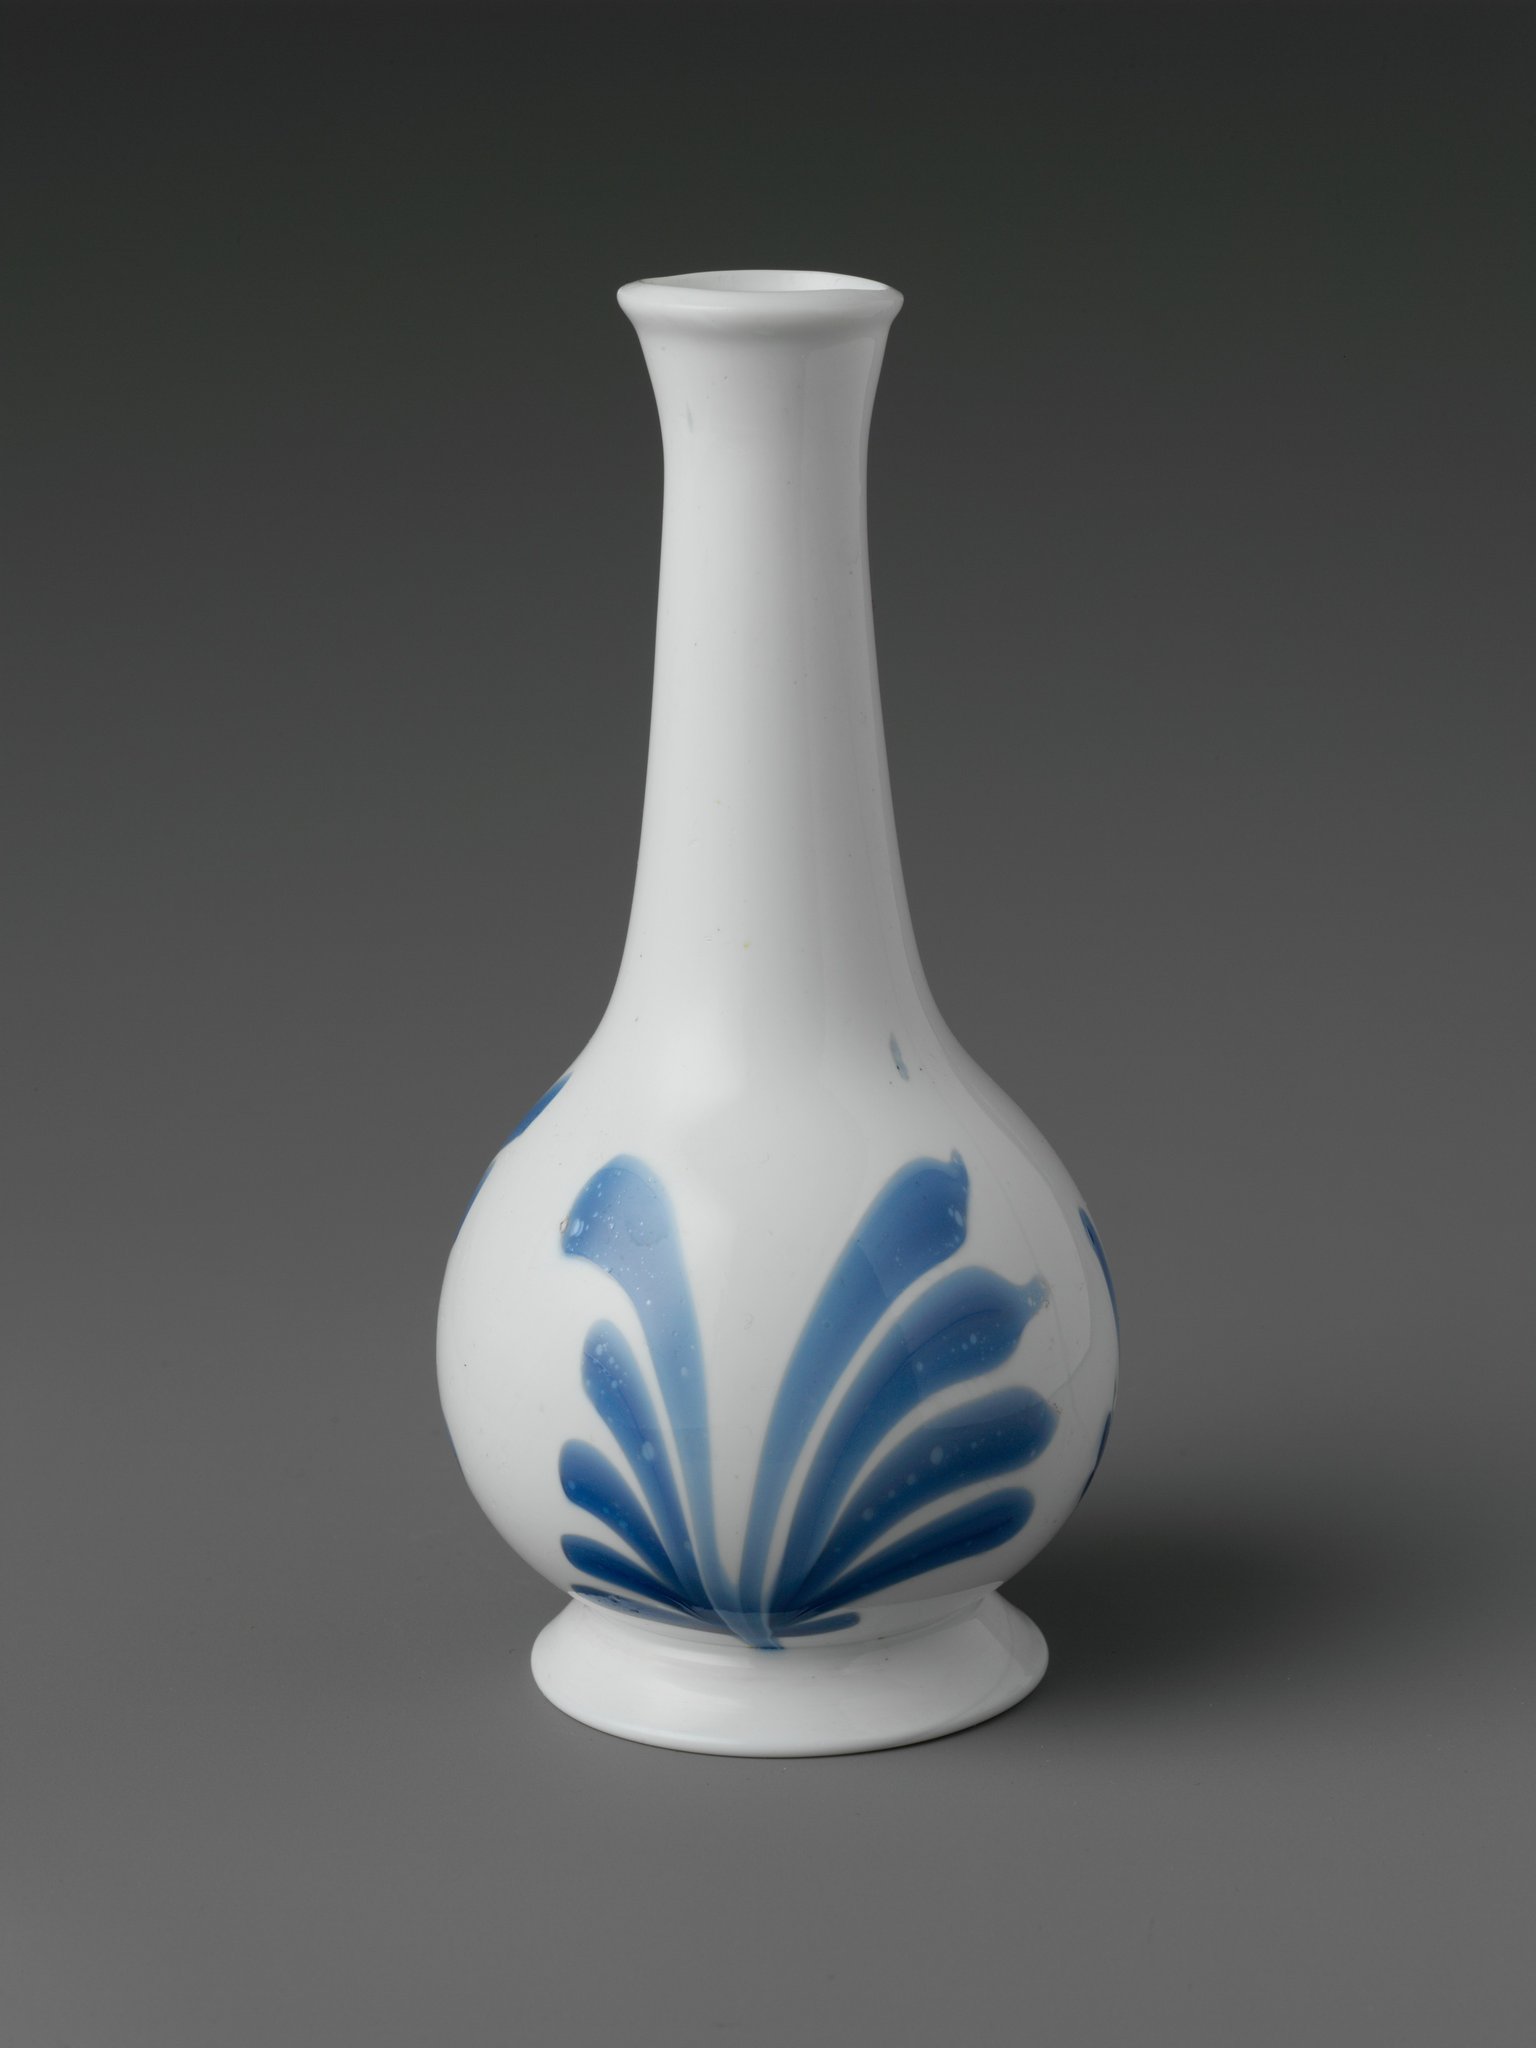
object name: bottle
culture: british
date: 1760-1770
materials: glass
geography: england